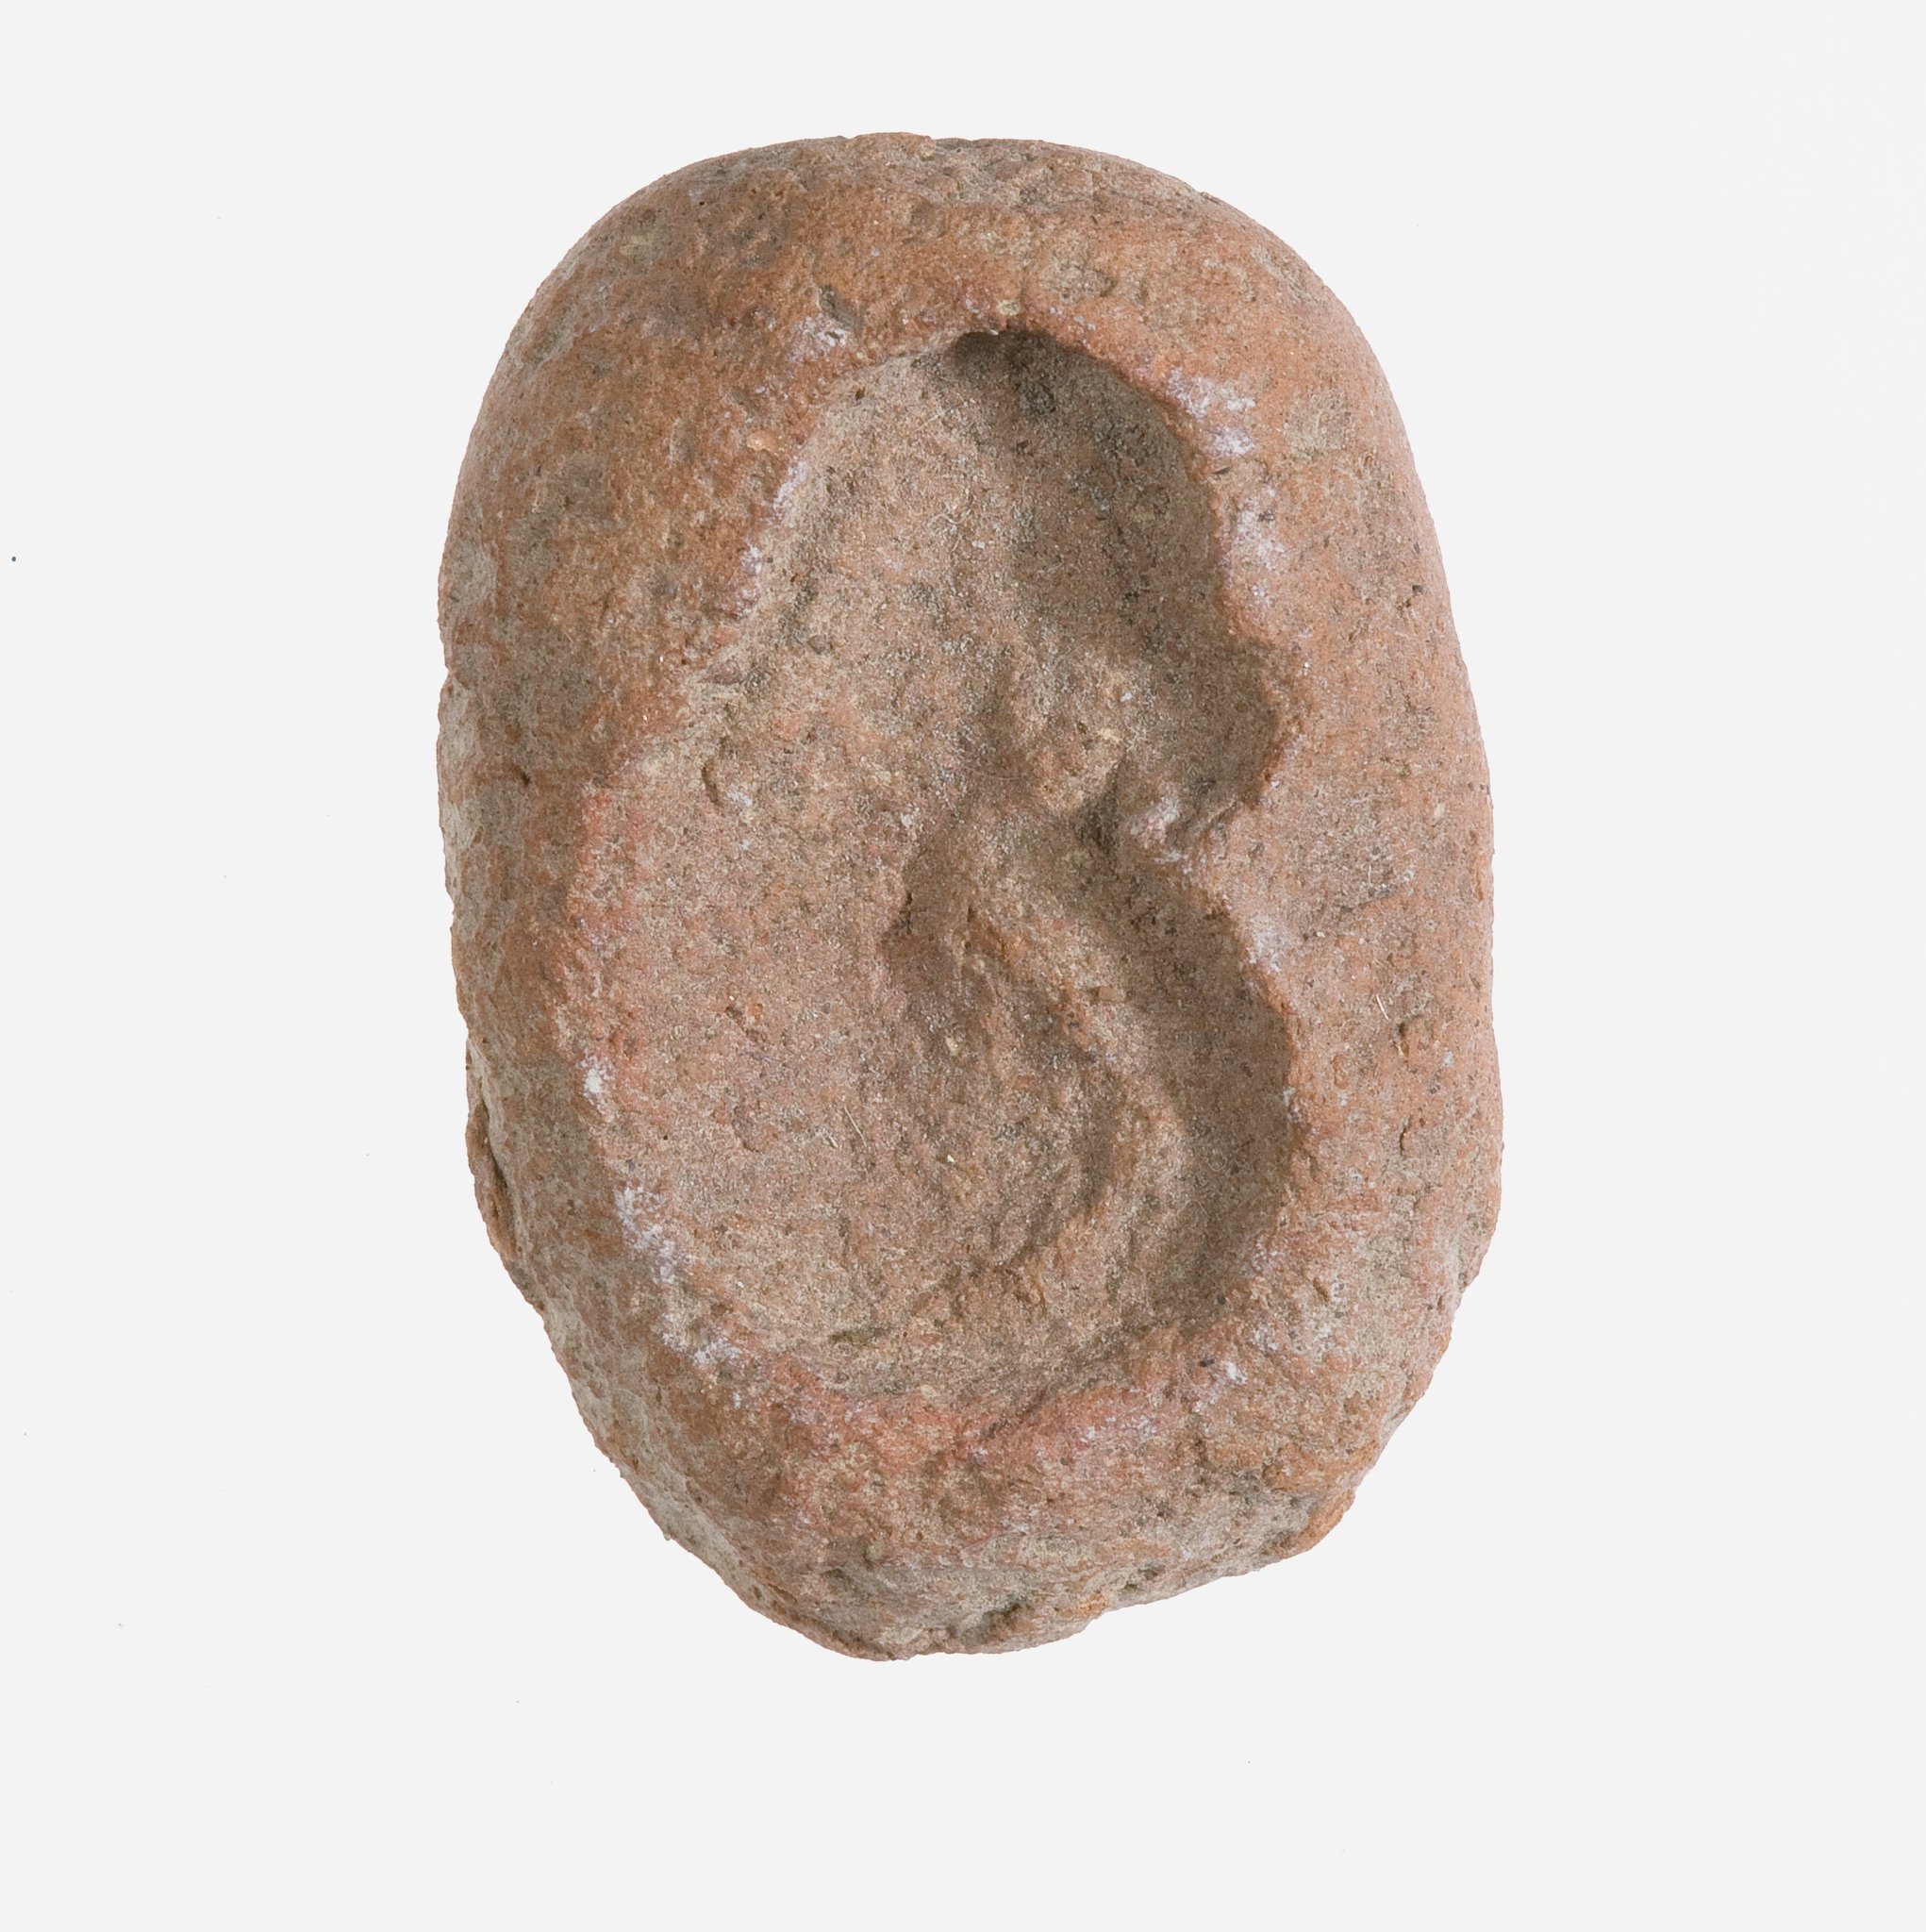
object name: mold, amulet, ear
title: Mold for an Ear Amulet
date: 1390-1352 BCE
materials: pottery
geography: egypt